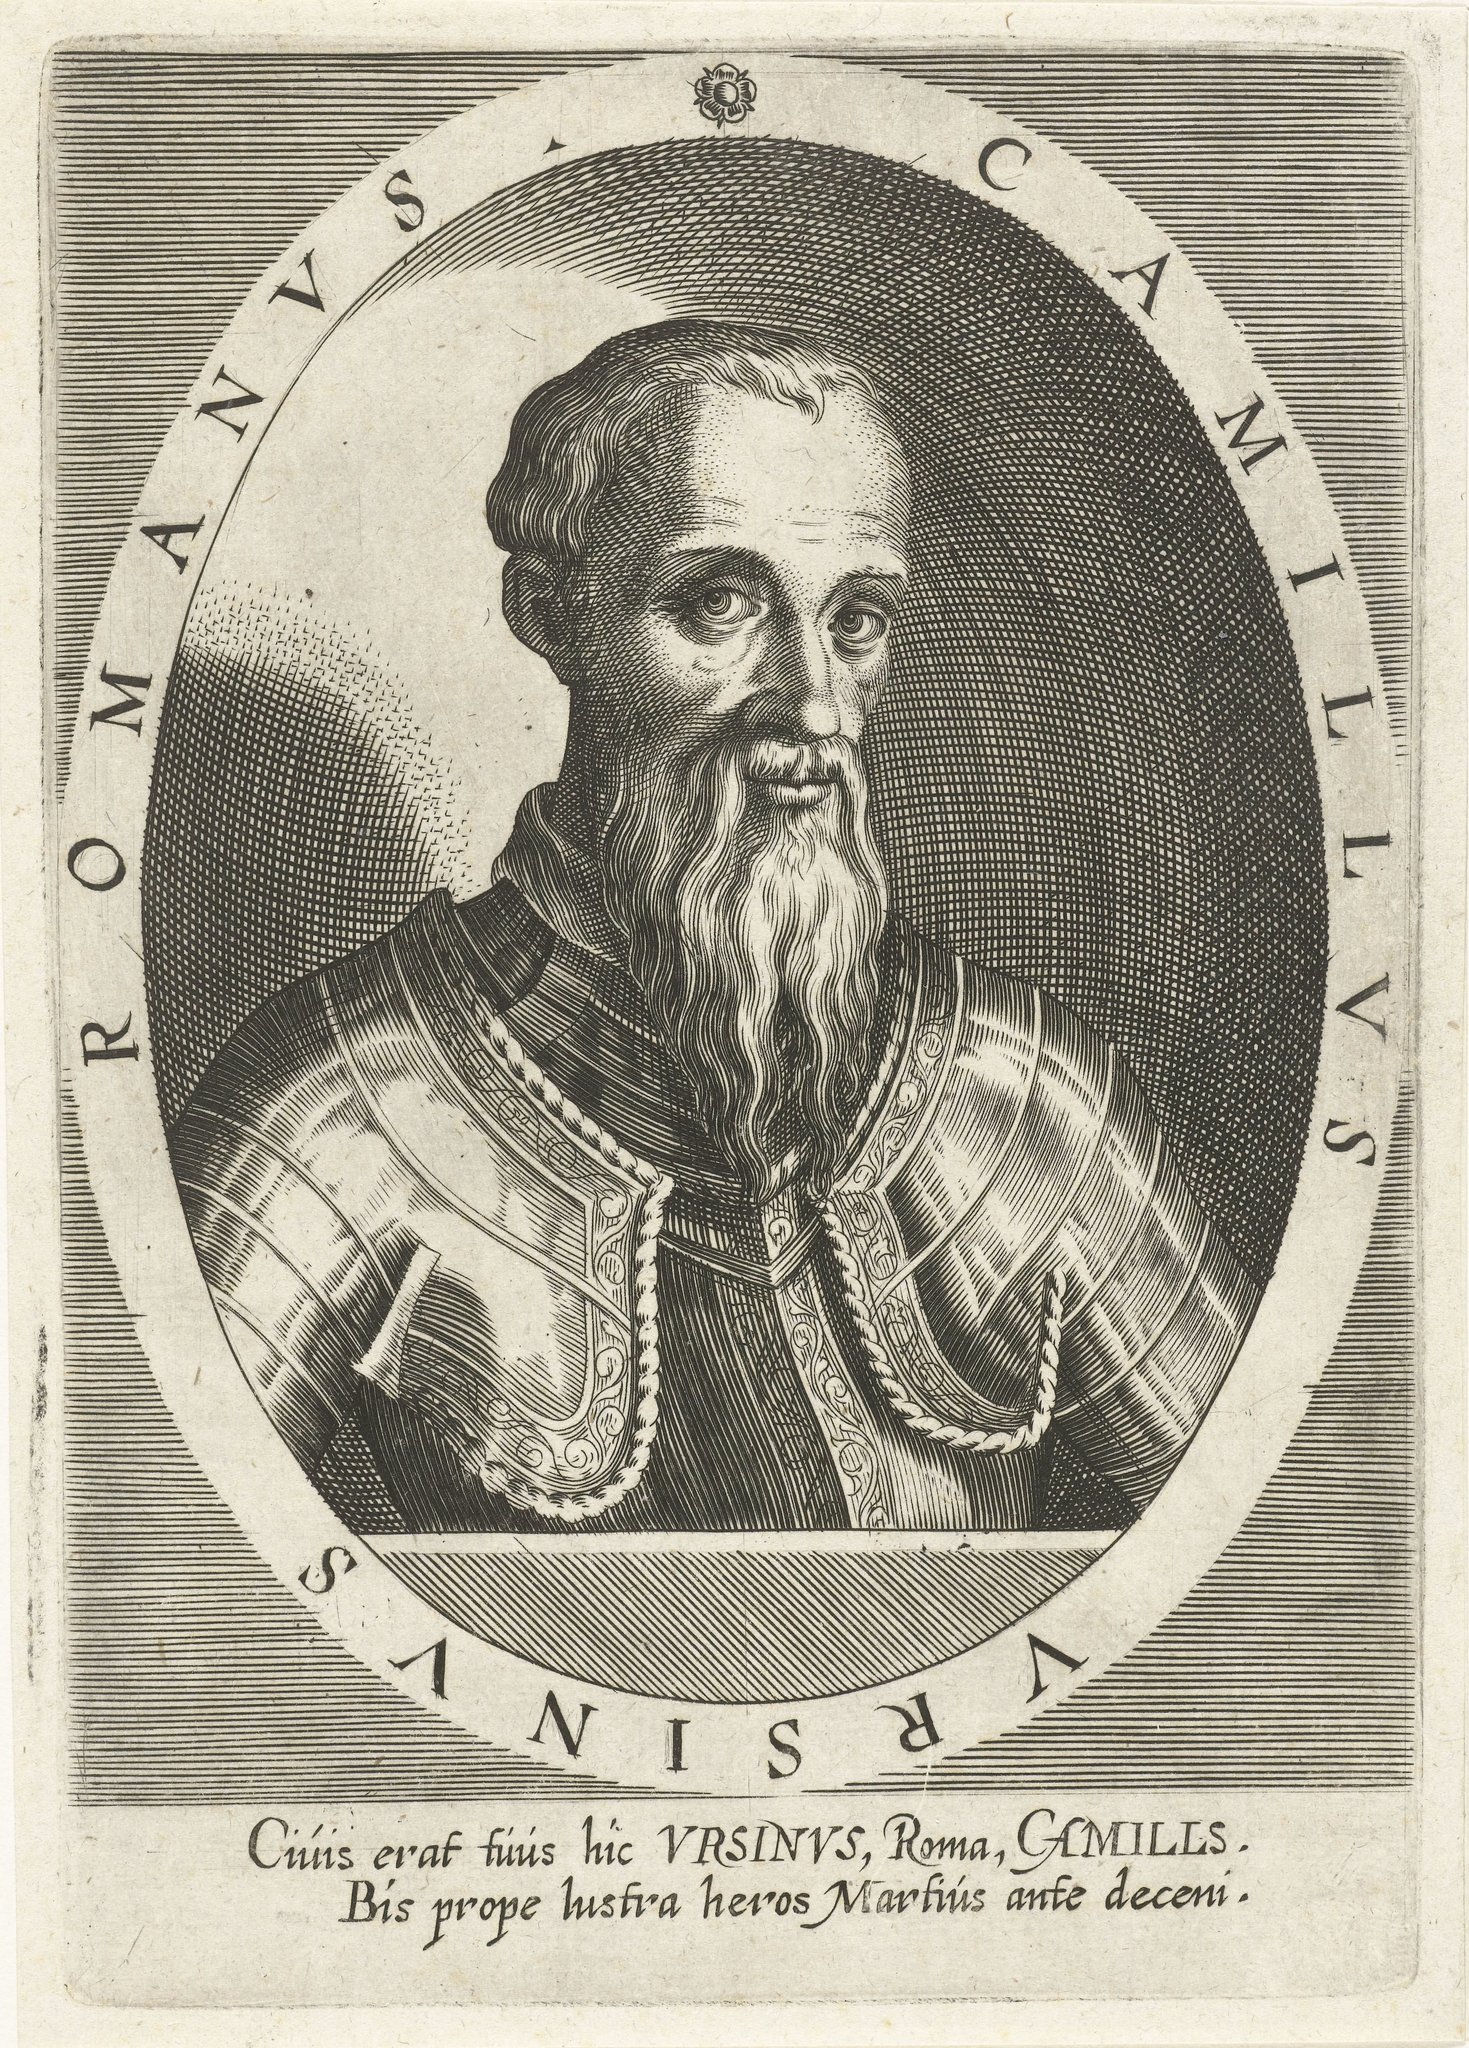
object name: print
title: Portretten van bekende personen uit de zestiende eeuw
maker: dominicus custos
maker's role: print maker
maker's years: 1560-1615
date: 1600-1604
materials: paper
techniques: engraving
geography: augsburg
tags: rome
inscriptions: collector's mark: Lugt 2228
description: Illustratie uit: D. Custos en M. Henning. Atrium heroicum Caesarum, regum aliorq. summatum ac procerum qui intra proximum seculum vixere, aut hodie supersunt, imaginib. Deel 1-4. Augsburg: D. Custos, 1600-1604.